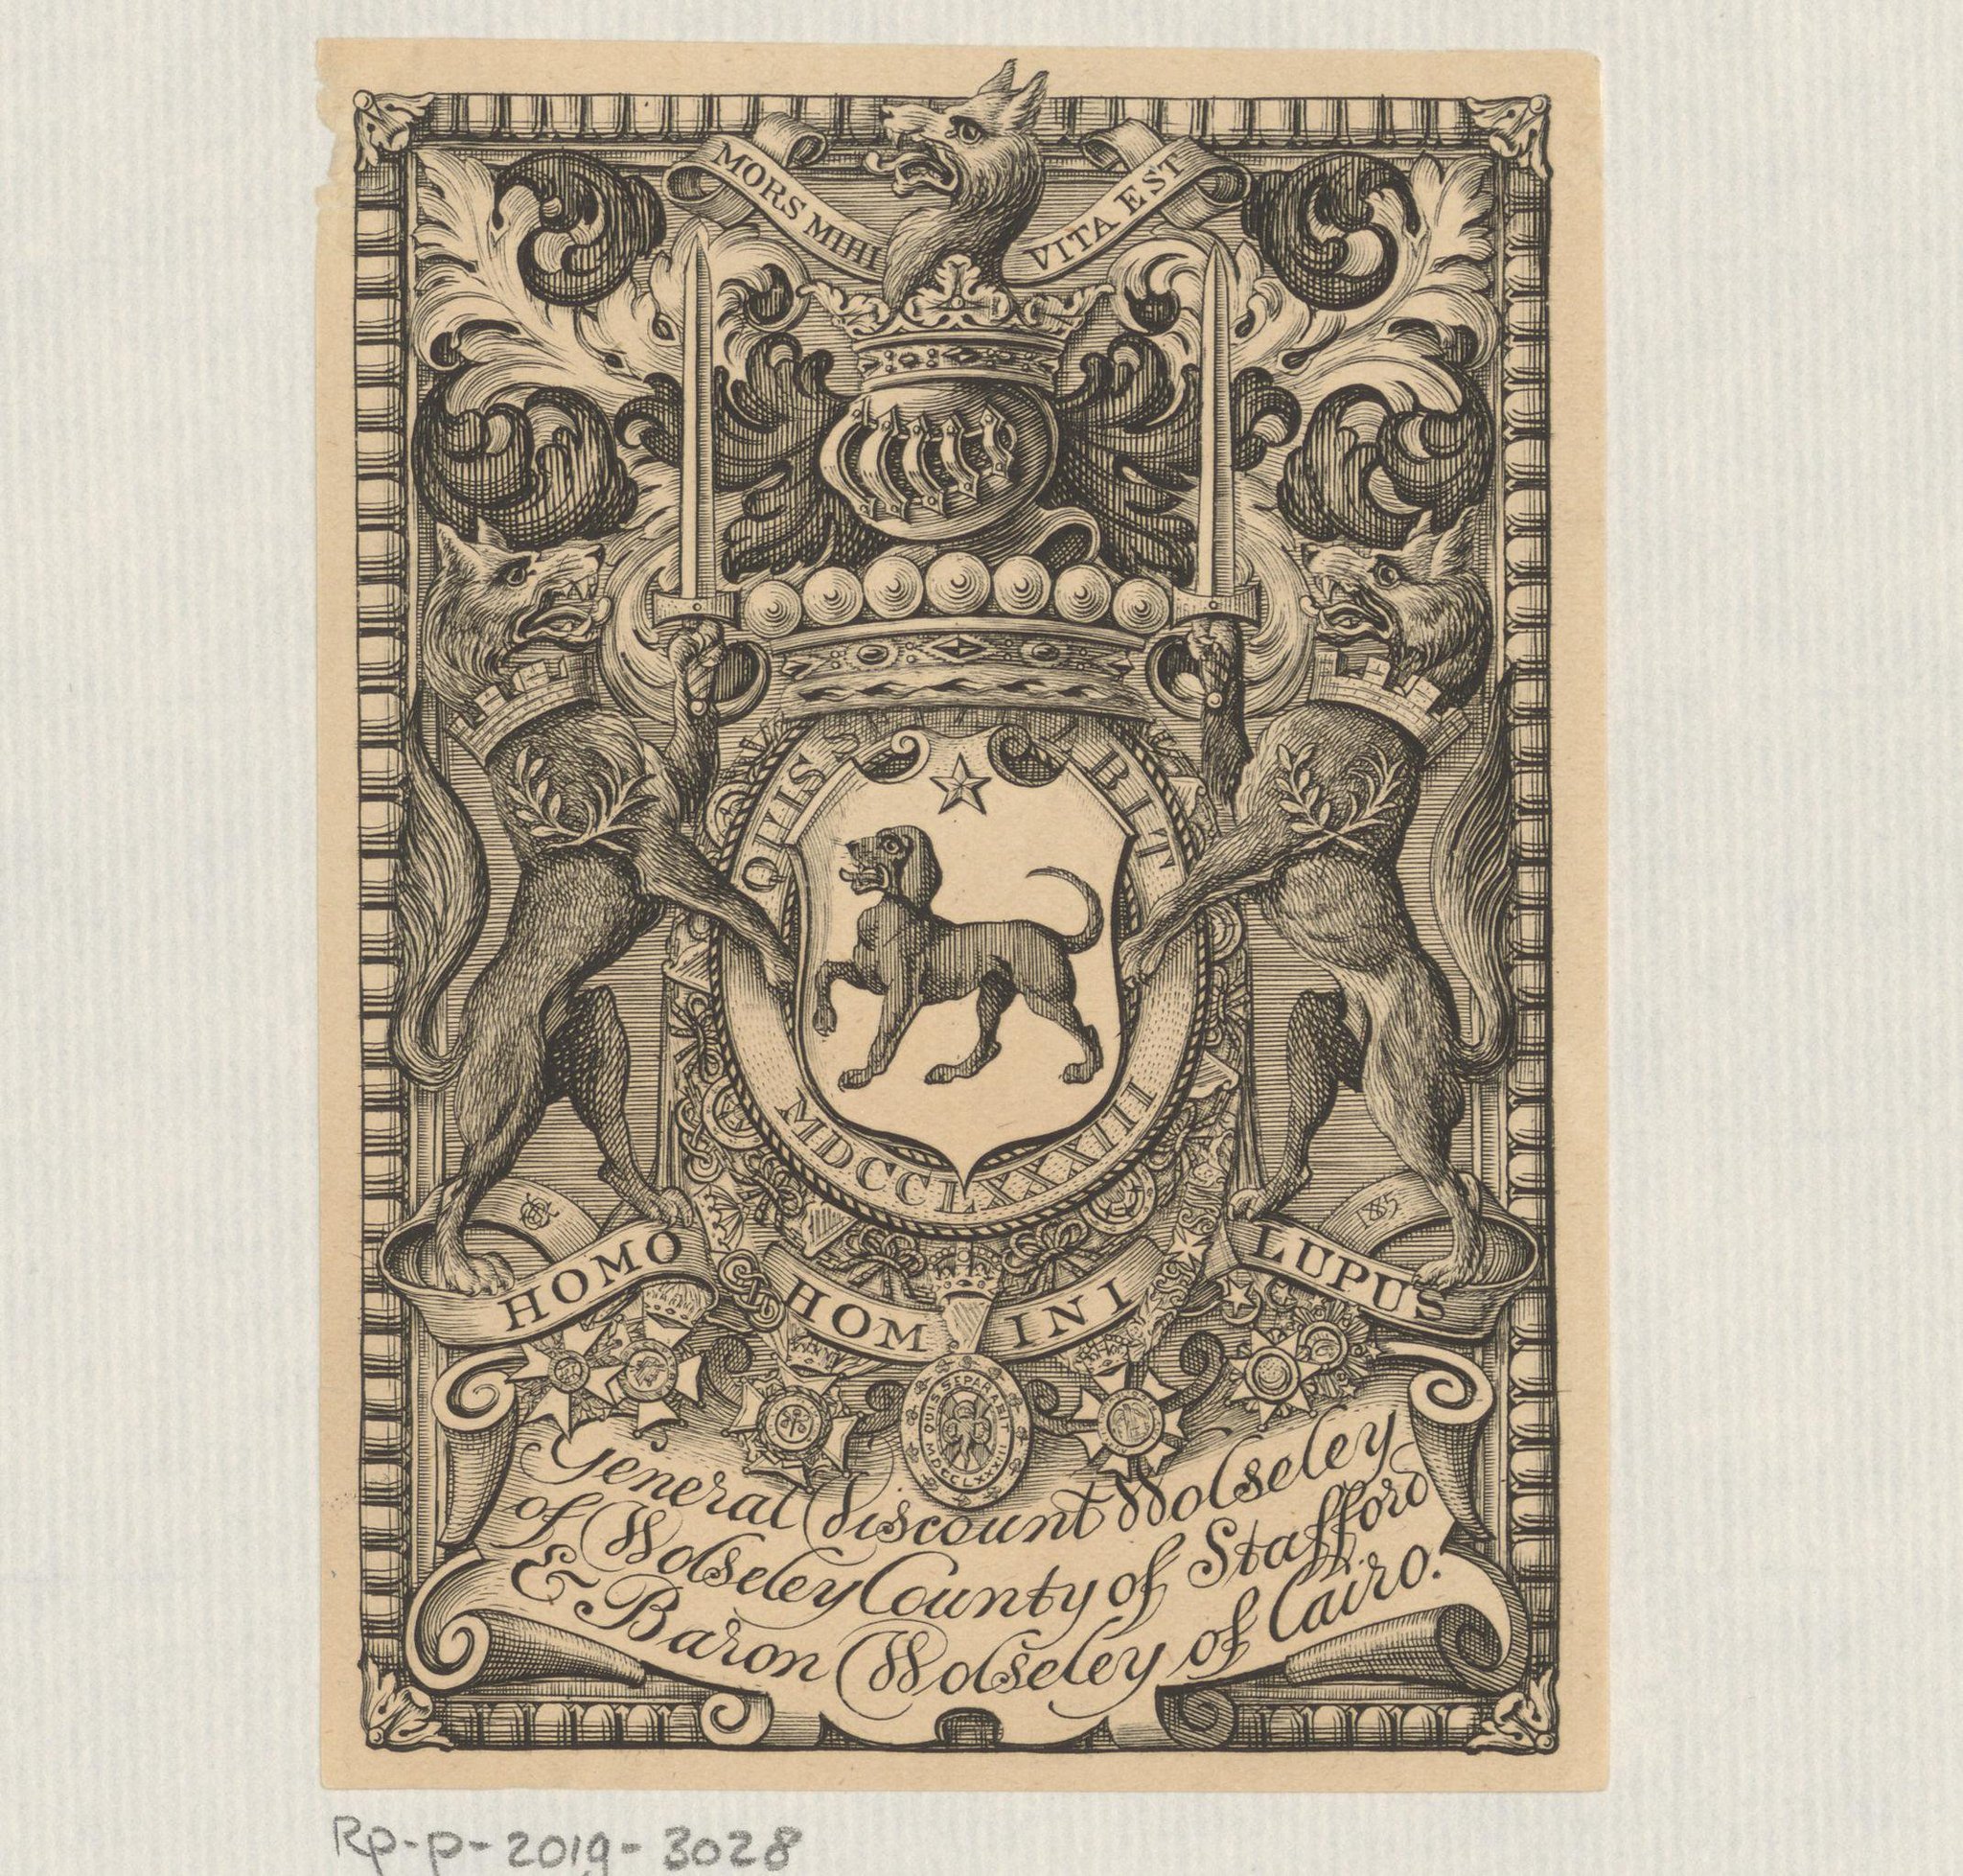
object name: bookplate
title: Ex libris van General Viscount Wolseley of Wolseley County of Stafford & Baron Wolseley of Cairo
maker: charles william sherborn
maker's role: print maker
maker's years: 1831-1912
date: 1885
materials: paper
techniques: engraving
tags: armorial bearing, heraldry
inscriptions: date